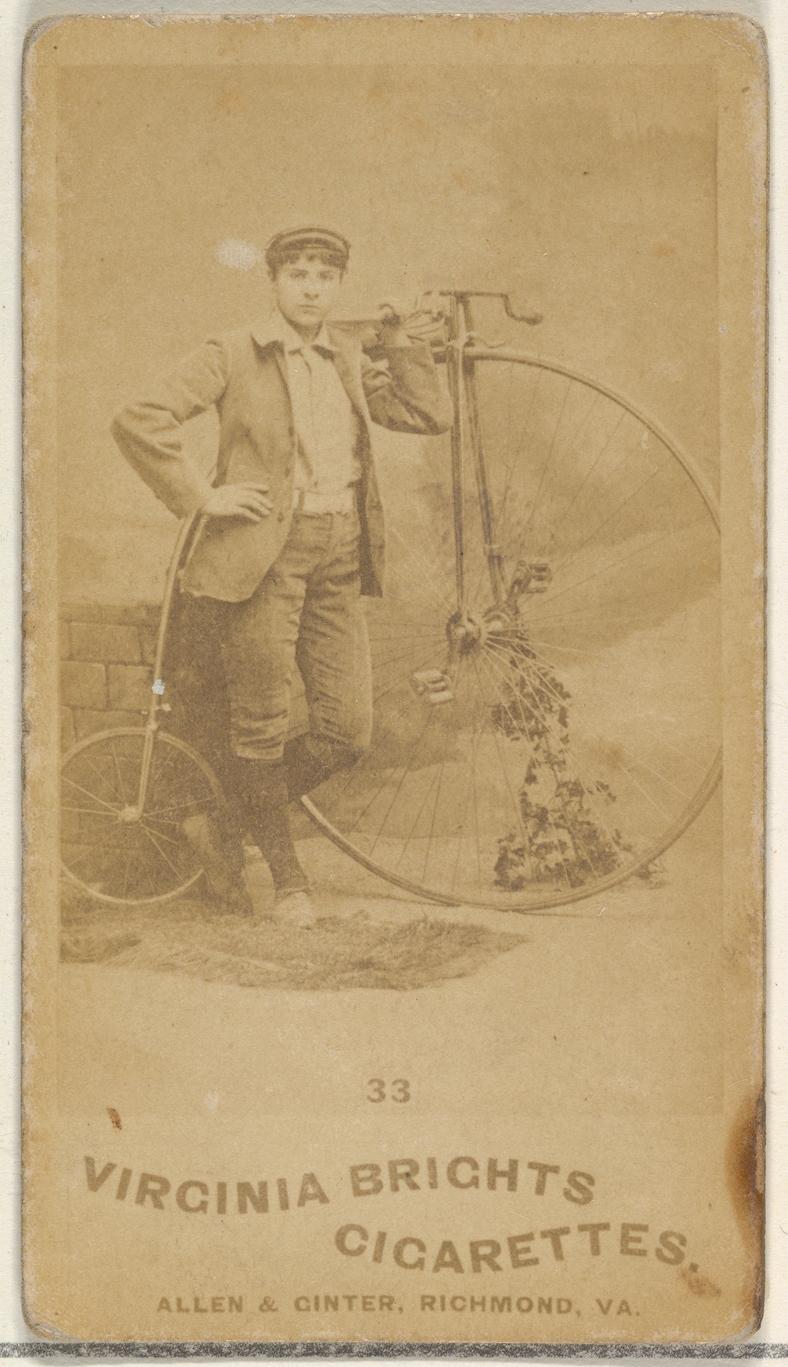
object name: photograph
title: Card 33, from the Girl Cyclists series (N49) for Virginia Brights Cigarettes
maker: allen & ginter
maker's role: publisher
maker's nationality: american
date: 1887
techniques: albumen silver print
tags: portraits,women,athletes,bicycles